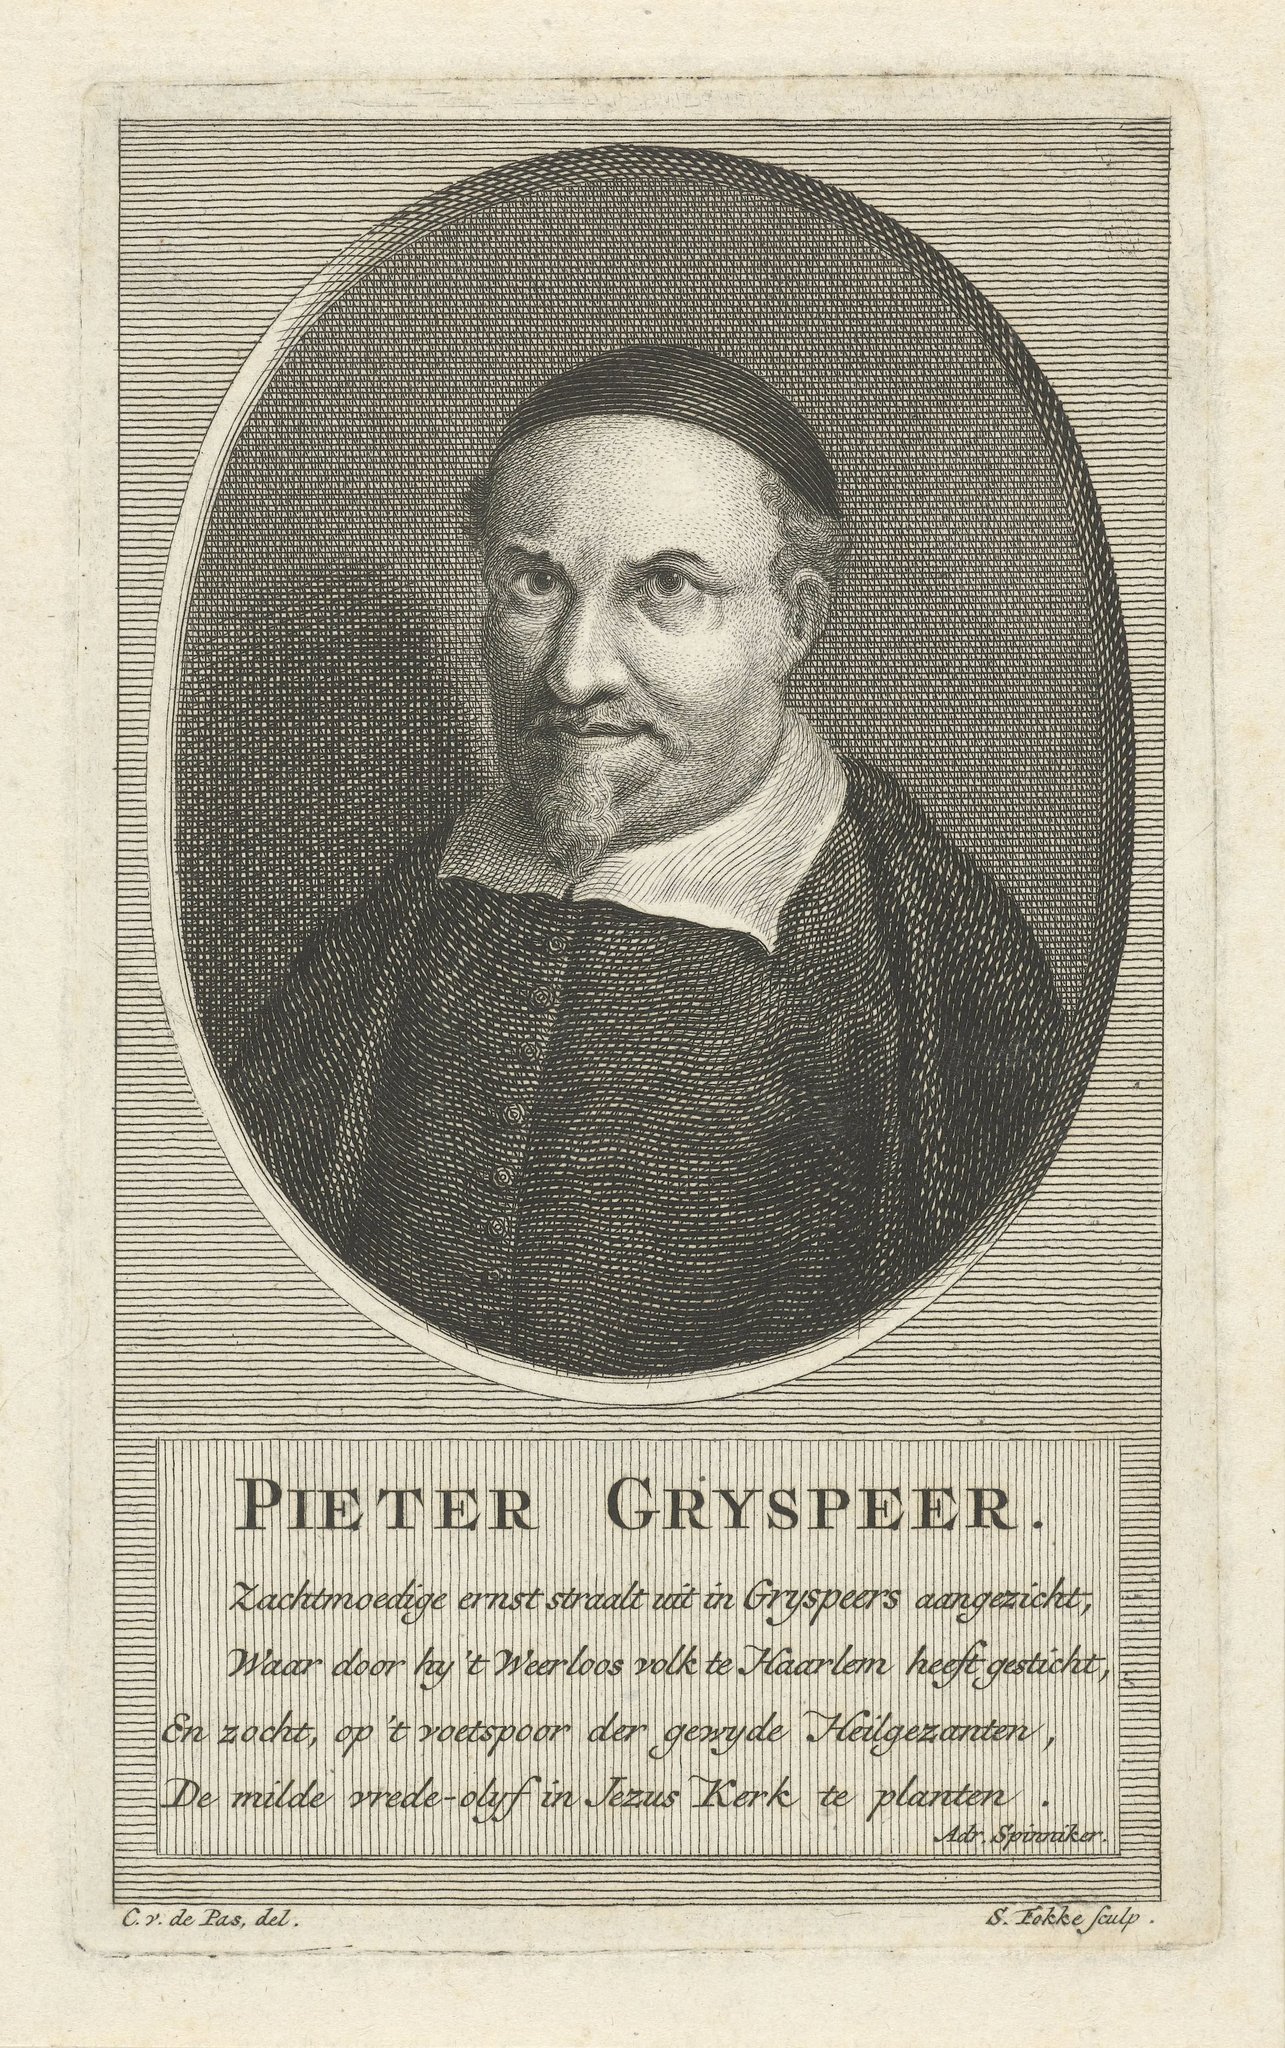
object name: print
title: Portret van Pieter Grijspeer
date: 1722-1784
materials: paper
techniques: engraving, etching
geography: amsterdam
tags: historical person (with name)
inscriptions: collector's mark: Lugt 2228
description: Portretbuste in ovaal van Pieter Grijspeer, naar links. Onder de voorstelling staat zijn naam en een vierregelige tekst in het Nederlands.